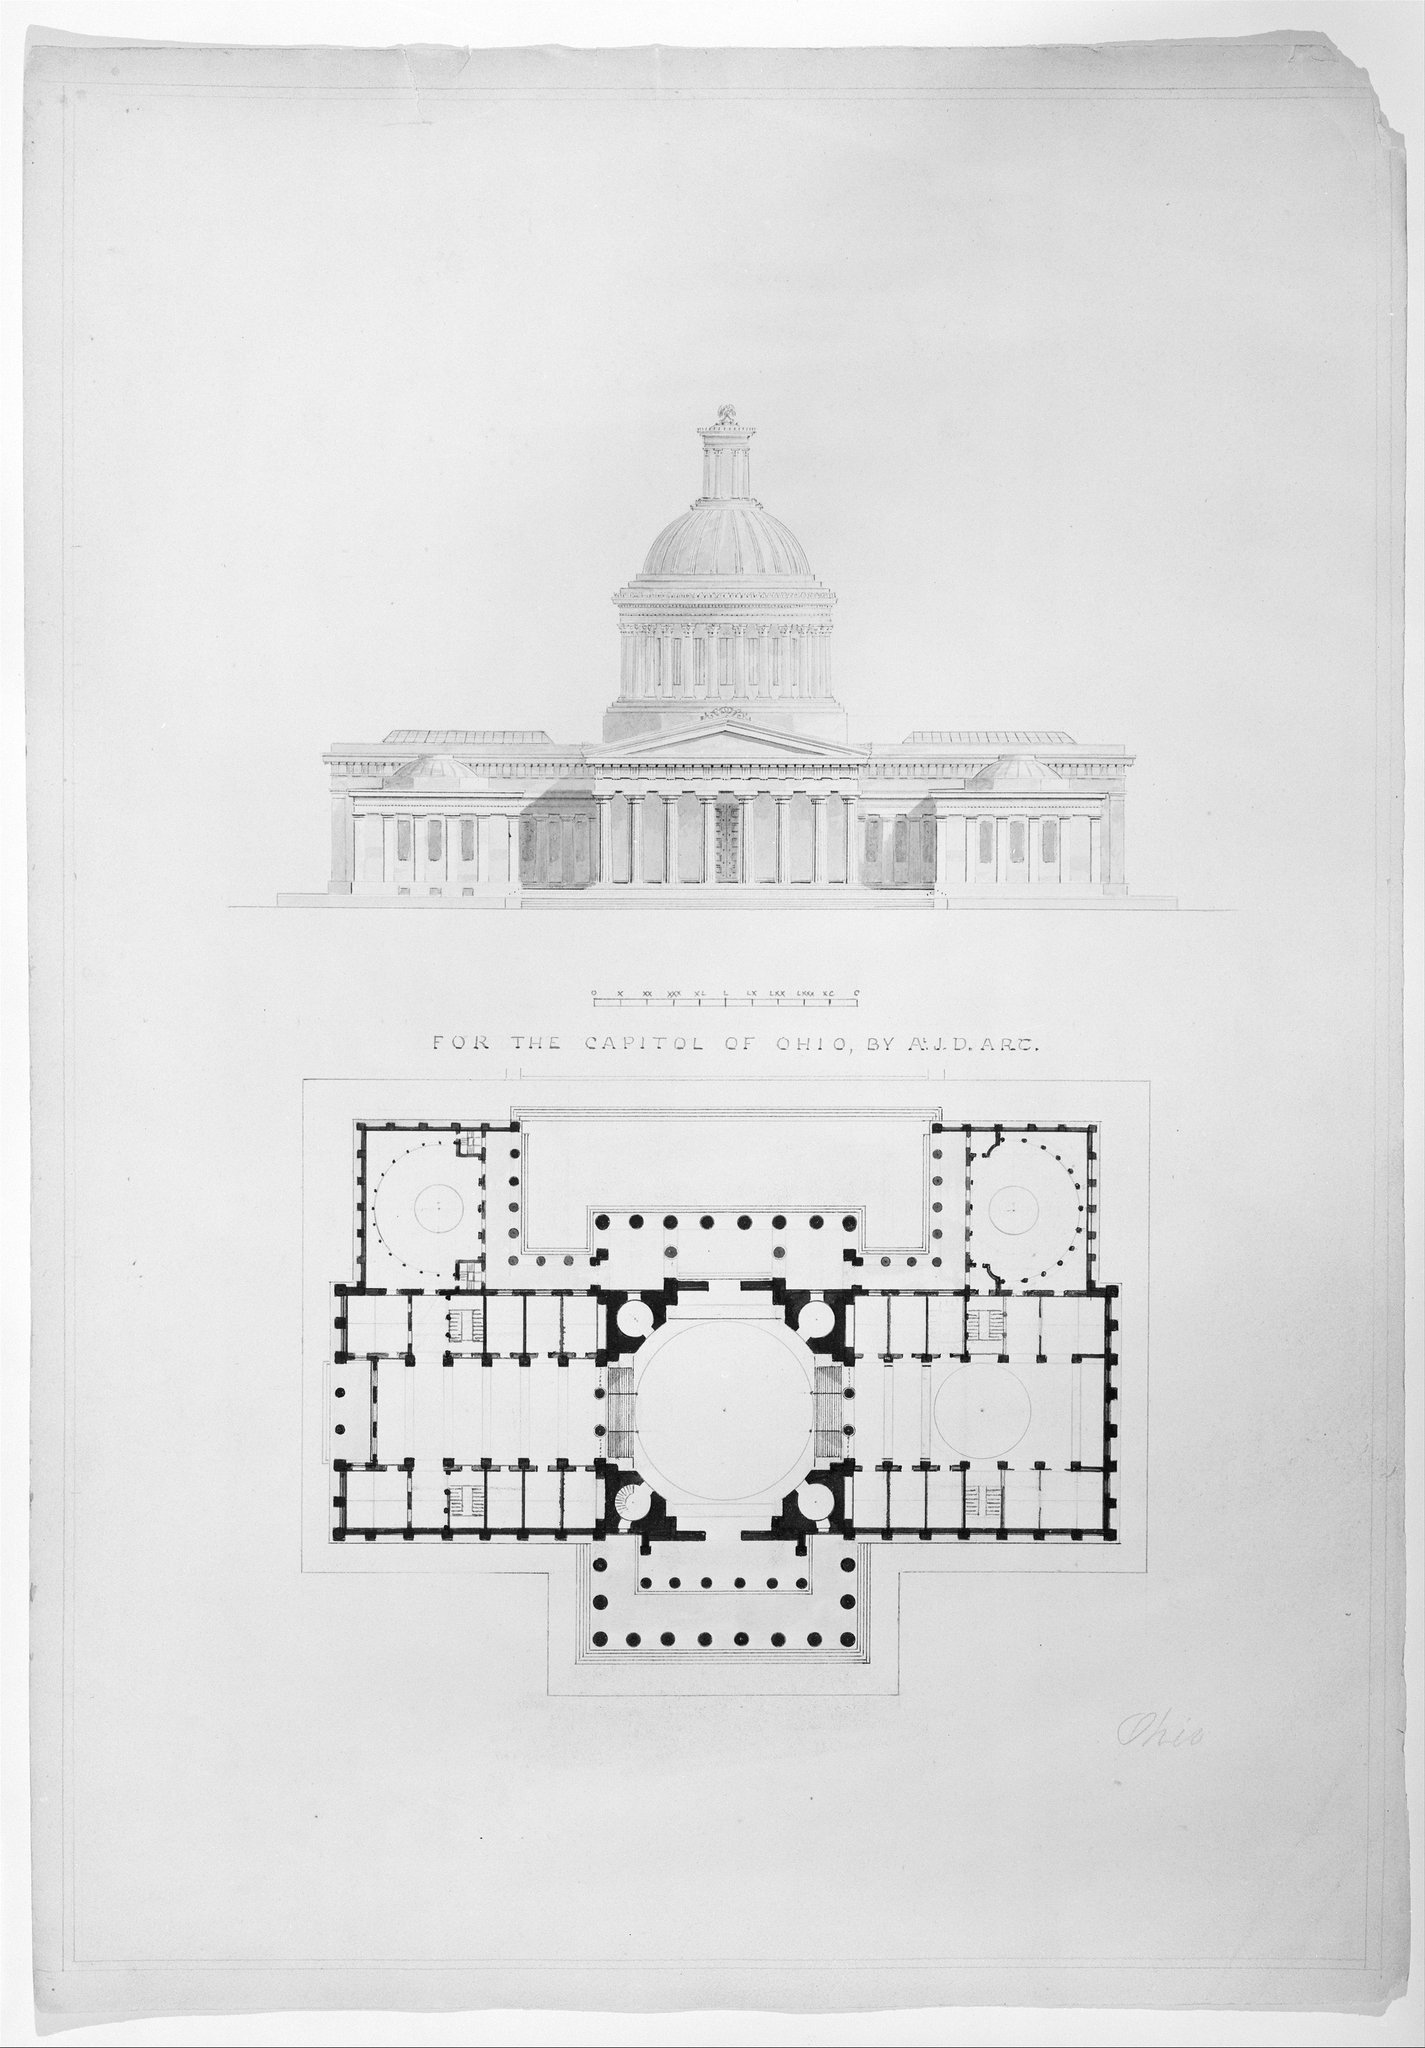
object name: drawing ornament architecture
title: For the Capitol of Ohio, by A.J.D. arch.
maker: alexander jackson davis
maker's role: artist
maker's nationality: american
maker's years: 1803-1892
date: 1839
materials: graphite, ink, watercolor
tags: architecture,buildings